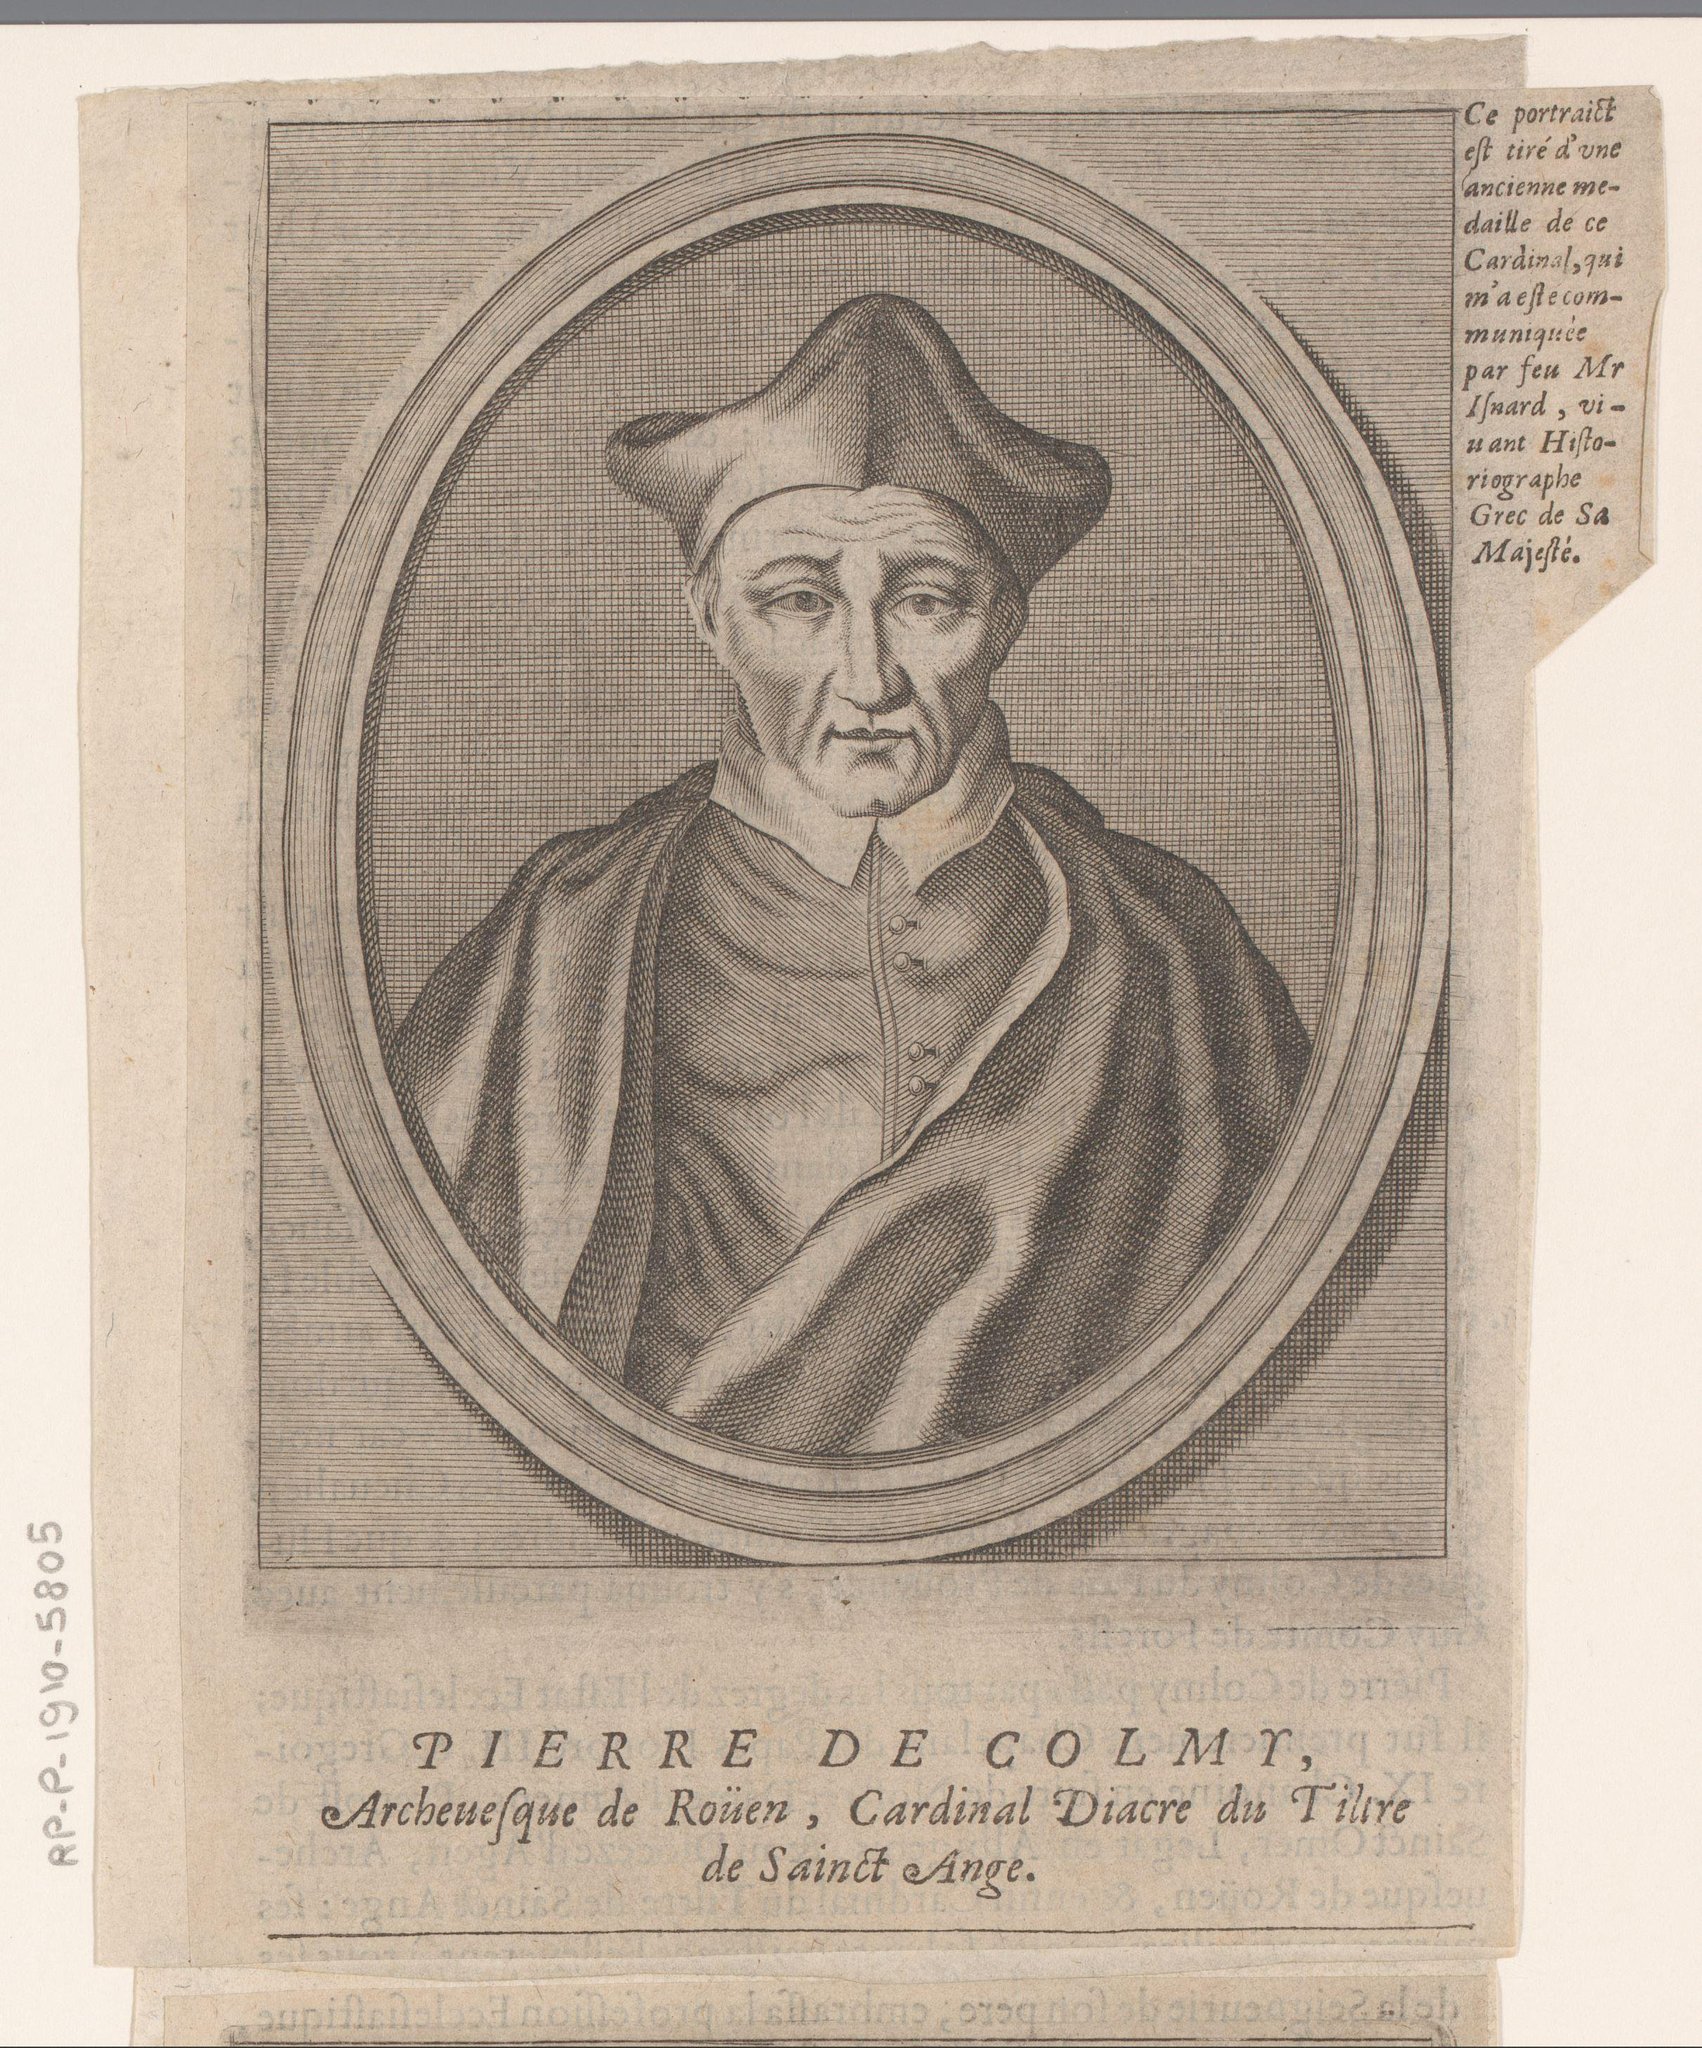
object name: book illustration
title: Pierre de Colmy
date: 1660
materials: paper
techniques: engraving, etching, letterpress printing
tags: archbishop, bishop, etc. (roman catholic), historical persons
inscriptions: collector's mark: Lugt 2228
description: Prent uit: Du Chesne, François. Histoire de tous les cardinaux françois de naissance, ou qui ont esté promeus au cardinalat. Parijs: François Du Chesne, 1660.